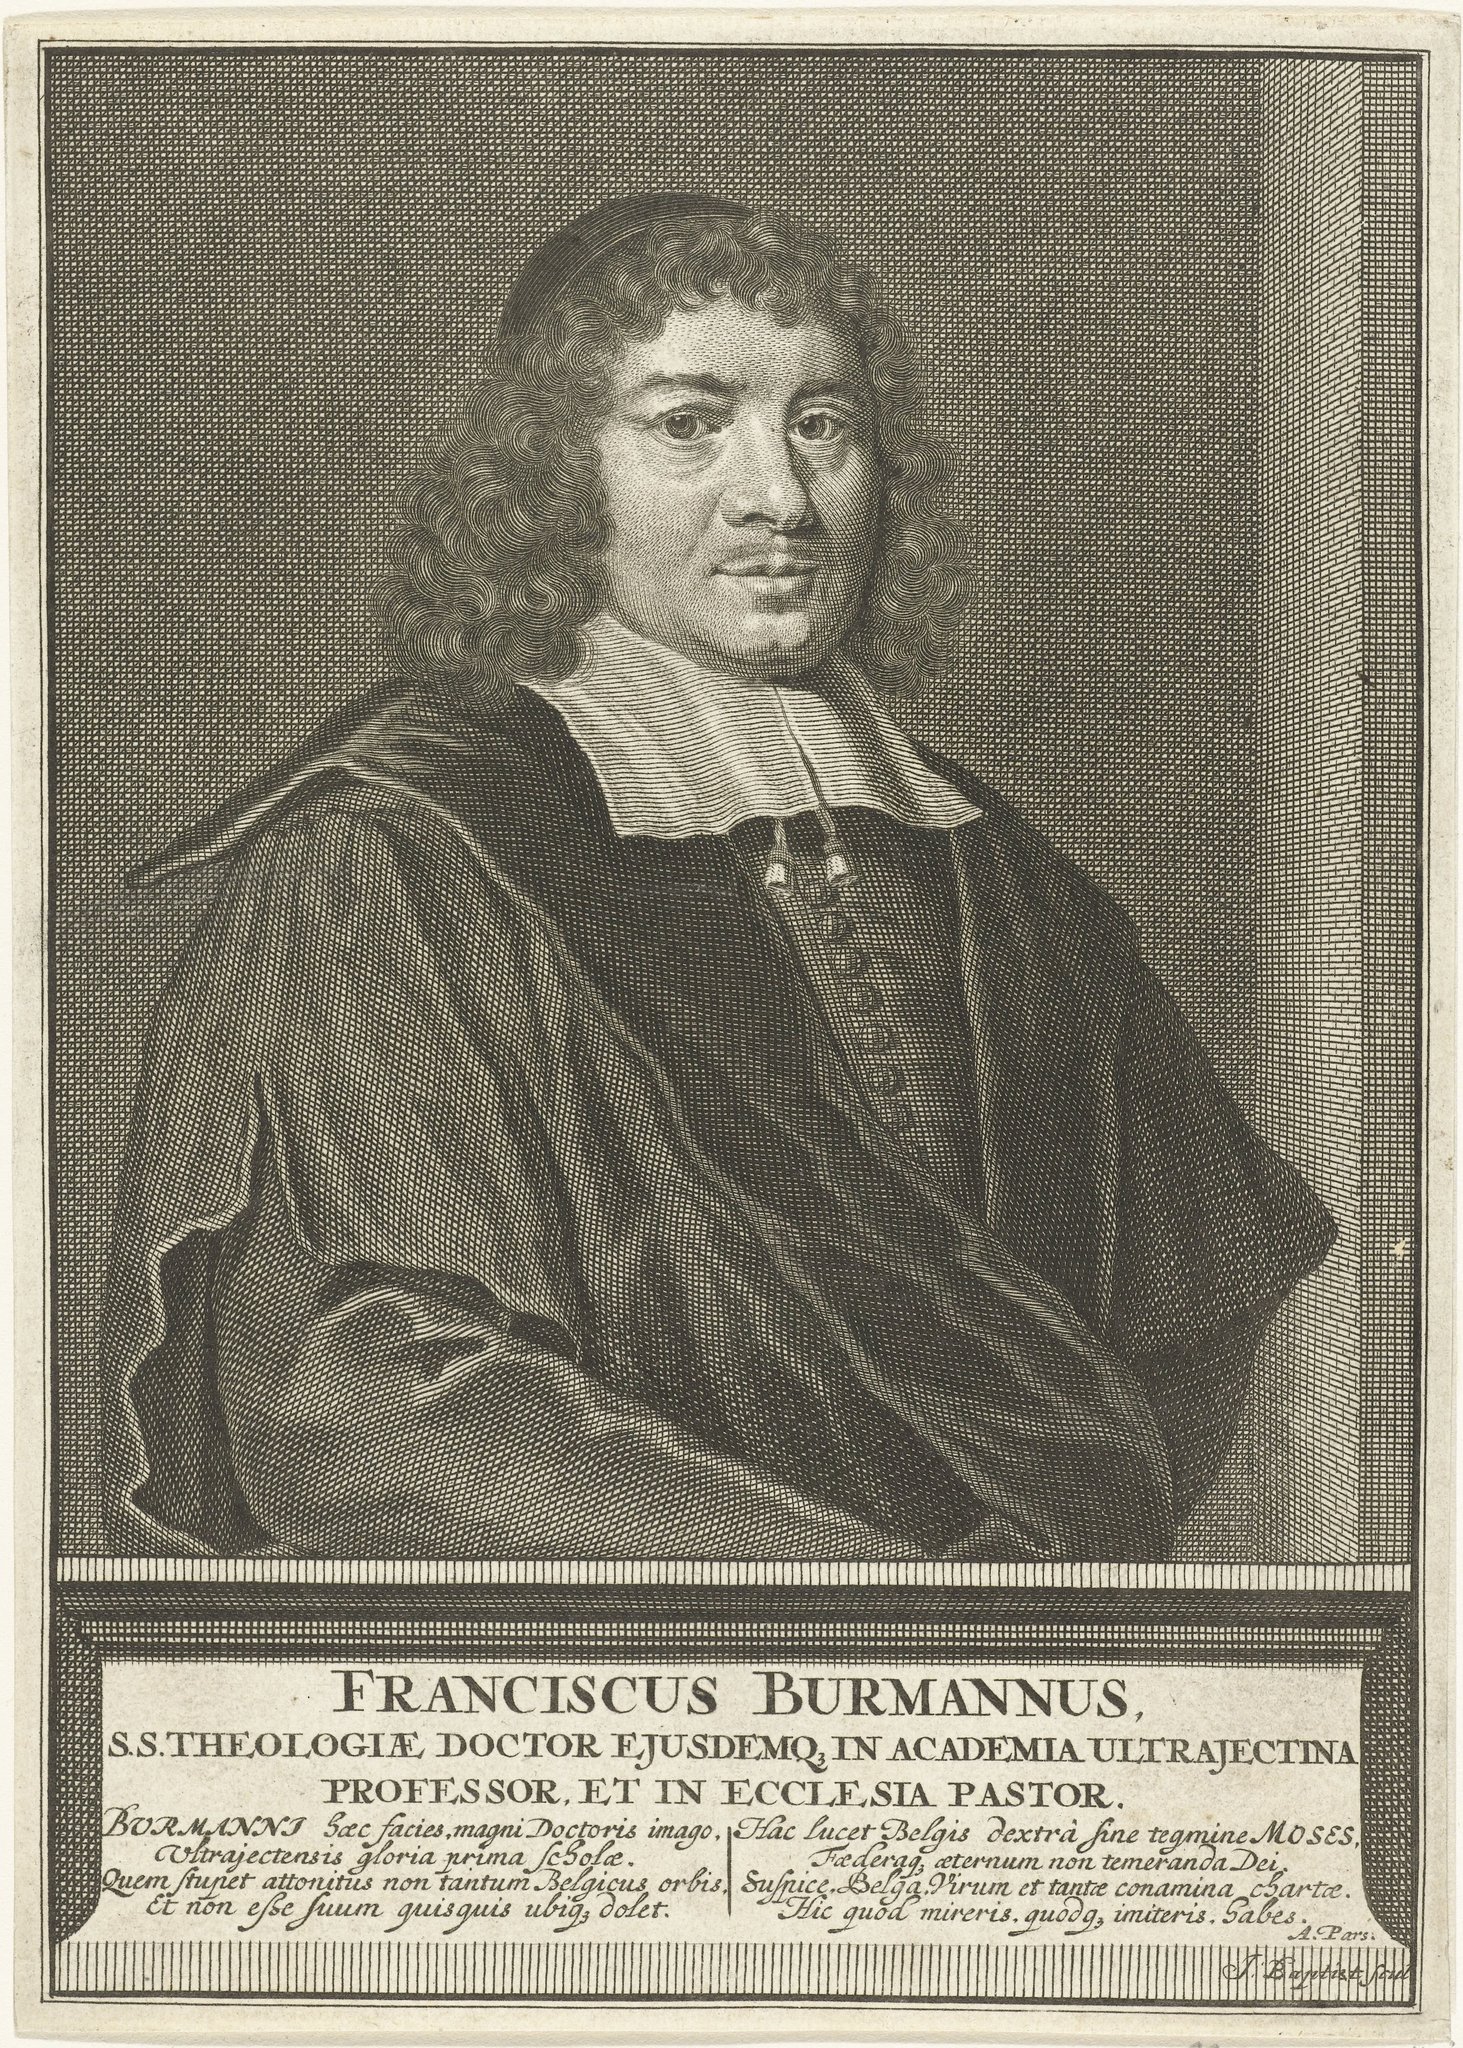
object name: print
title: Portret van Franciscus Burmannus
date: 1693-1704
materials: paper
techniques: engraving, etching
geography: amsterdam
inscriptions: collector's mark: Lugt 2228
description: Portret van Franciscus Burmannus, onder het portret zijn naam en titels en een vers in het Latijn.